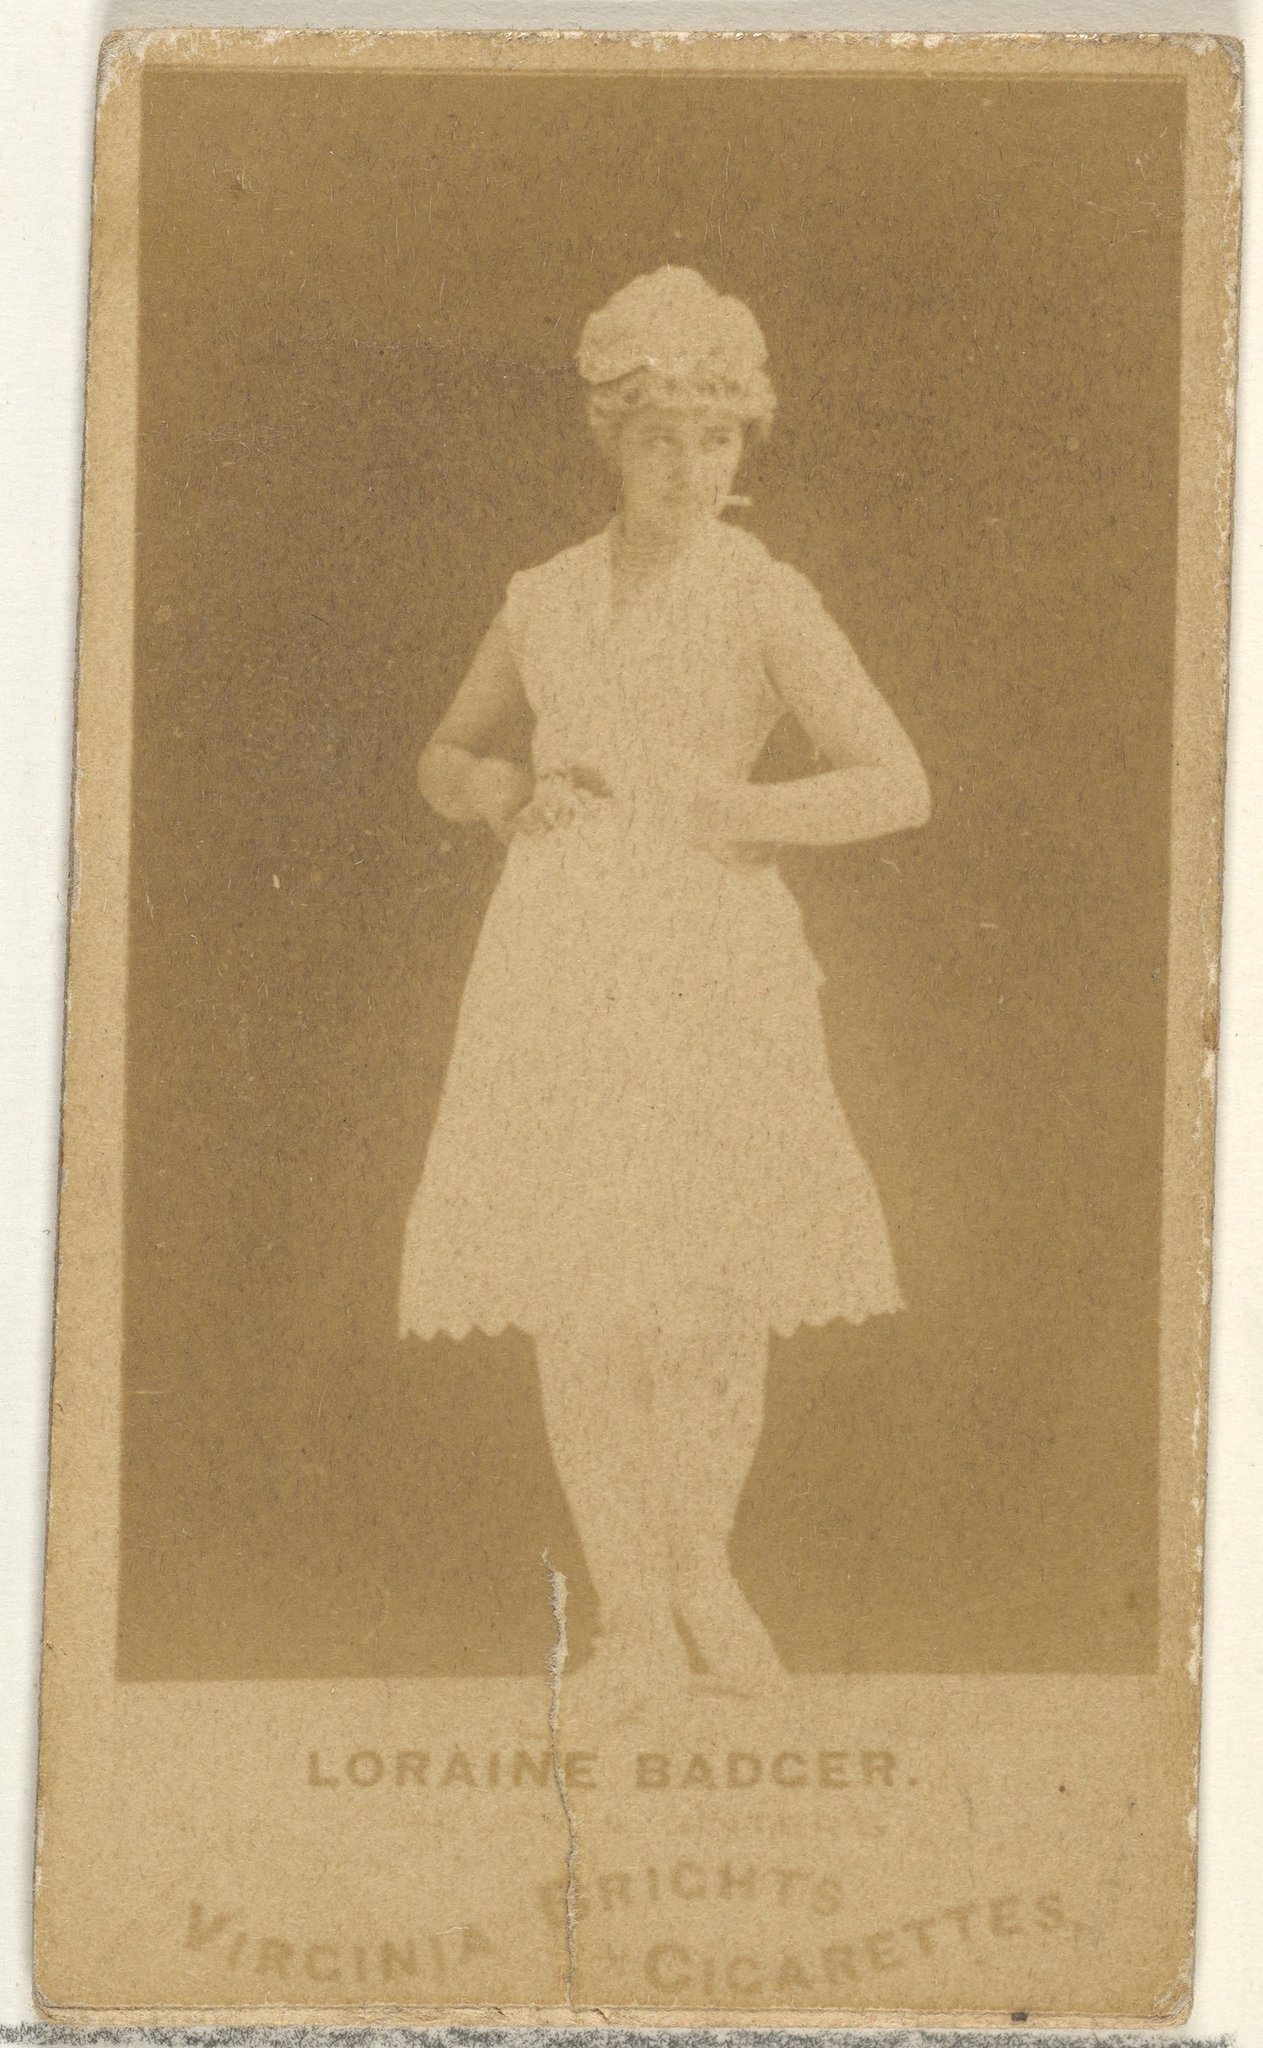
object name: photograph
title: Loraine Badger, from the Actors and Actresses series (N45, Type 1) for Virginia Brights Cigarettes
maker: allen & ginter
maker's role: publisher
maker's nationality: american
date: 1888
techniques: albumen silver print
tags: portraits,women,actresses